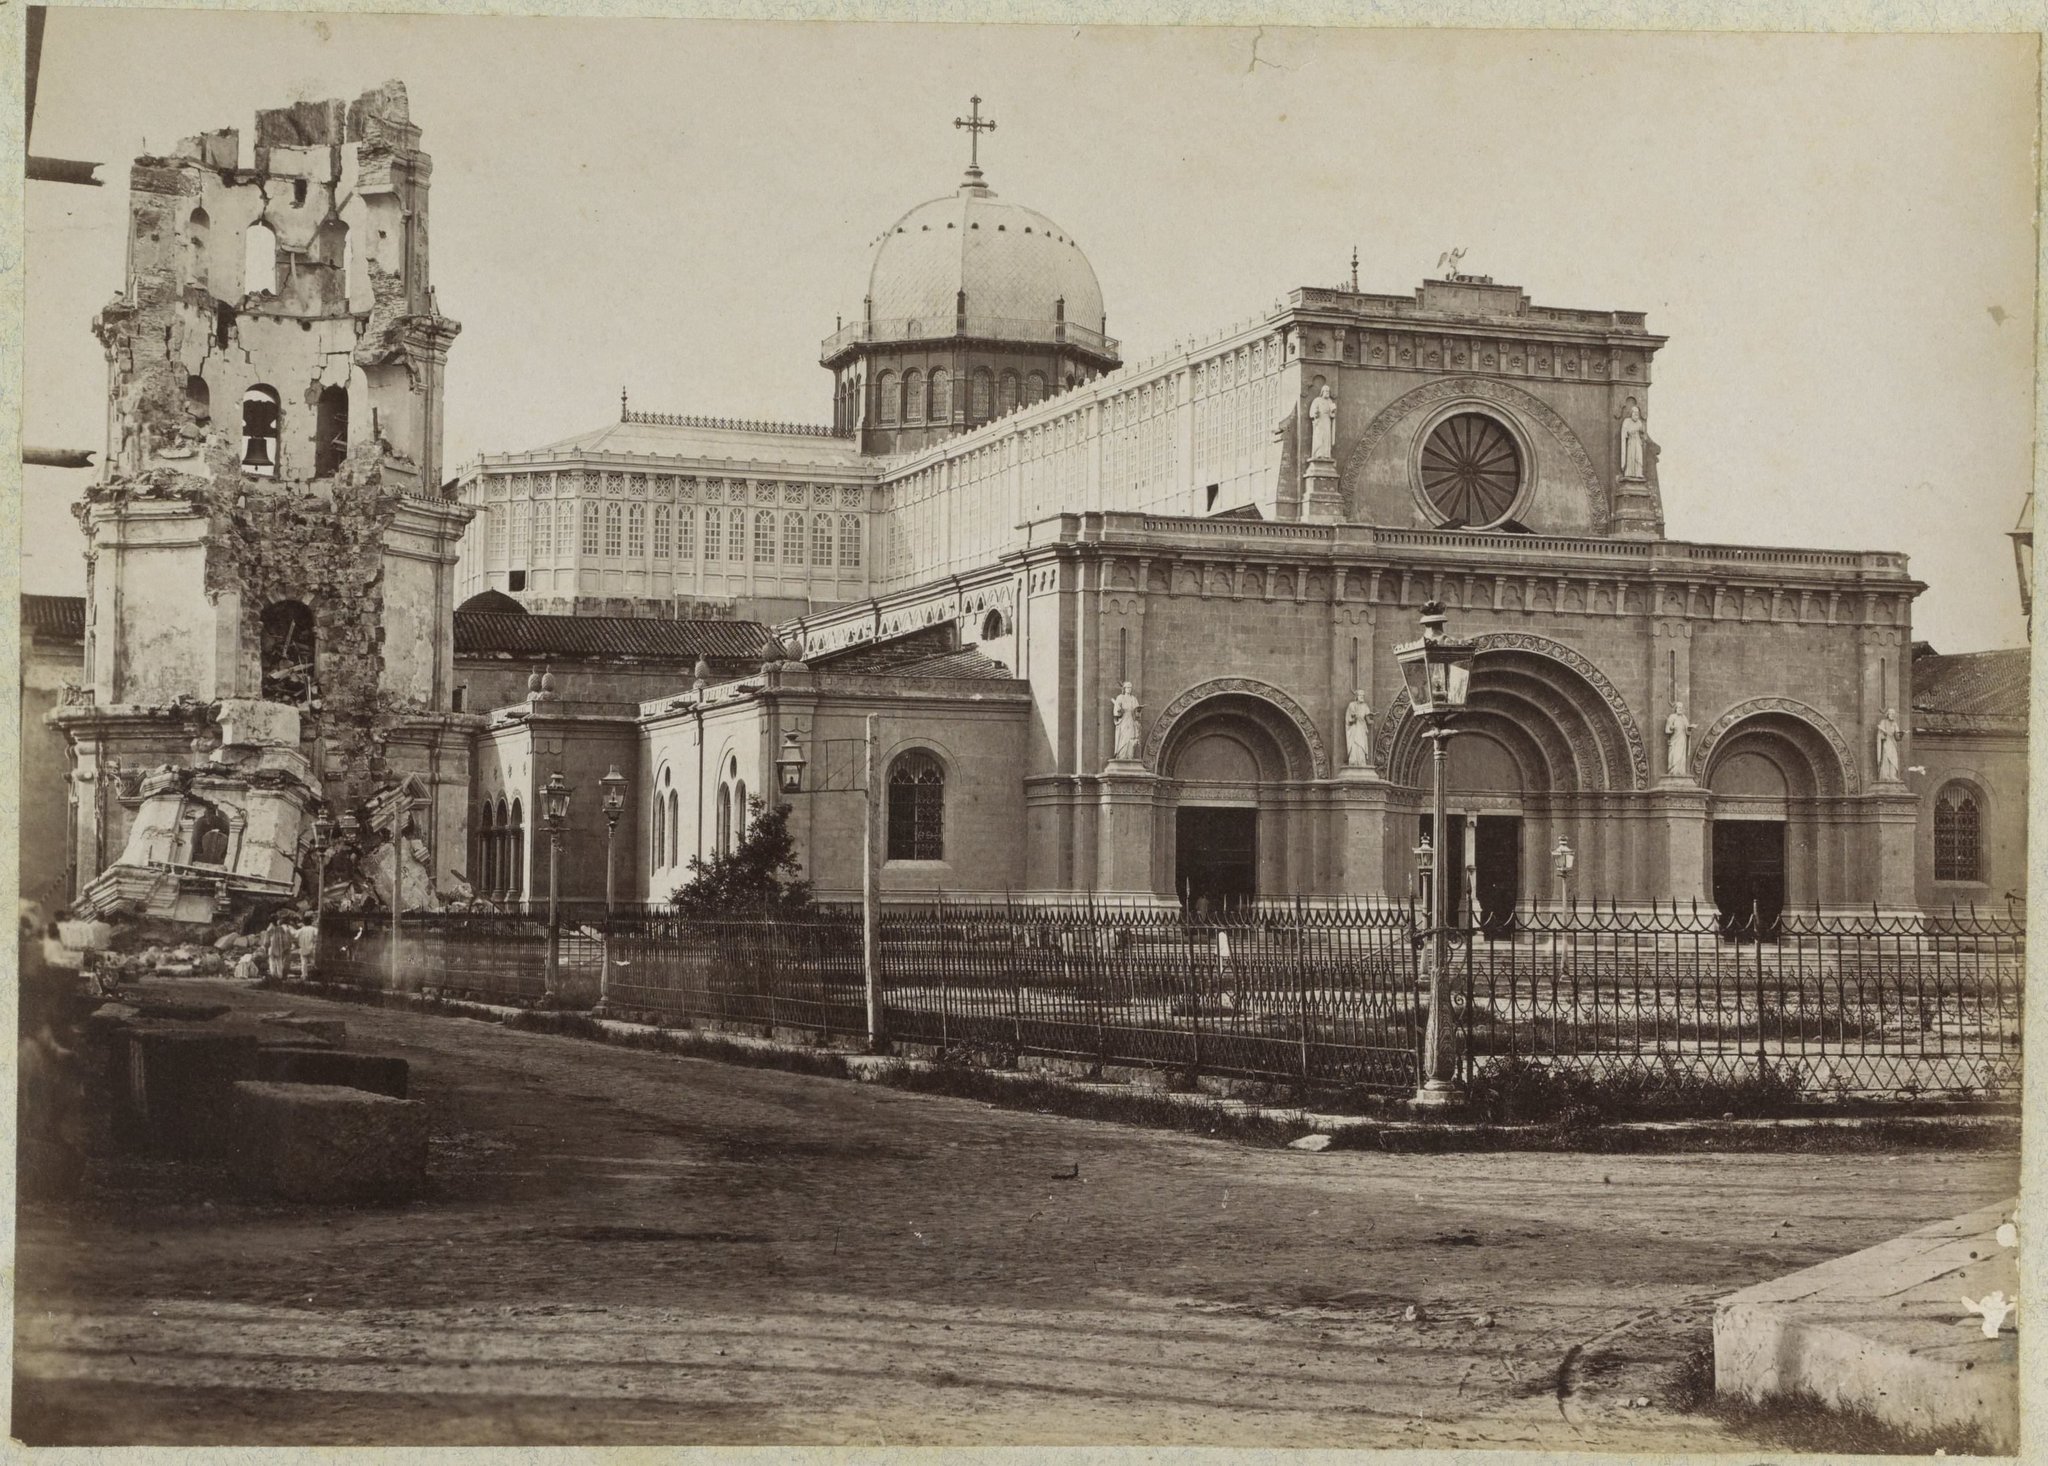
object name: photograph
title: Kathedraal van Manila met door aardbeving van juli 1880 verwoeste klokkentoren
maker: Anonymous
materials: paper, photographic support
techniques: albumen print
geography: manilla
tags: consequences of an earthquake, church (exterior), parts of church exterior and annexes: tower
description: Onderdeel van Fotoalbum van een reis naar Manilla.